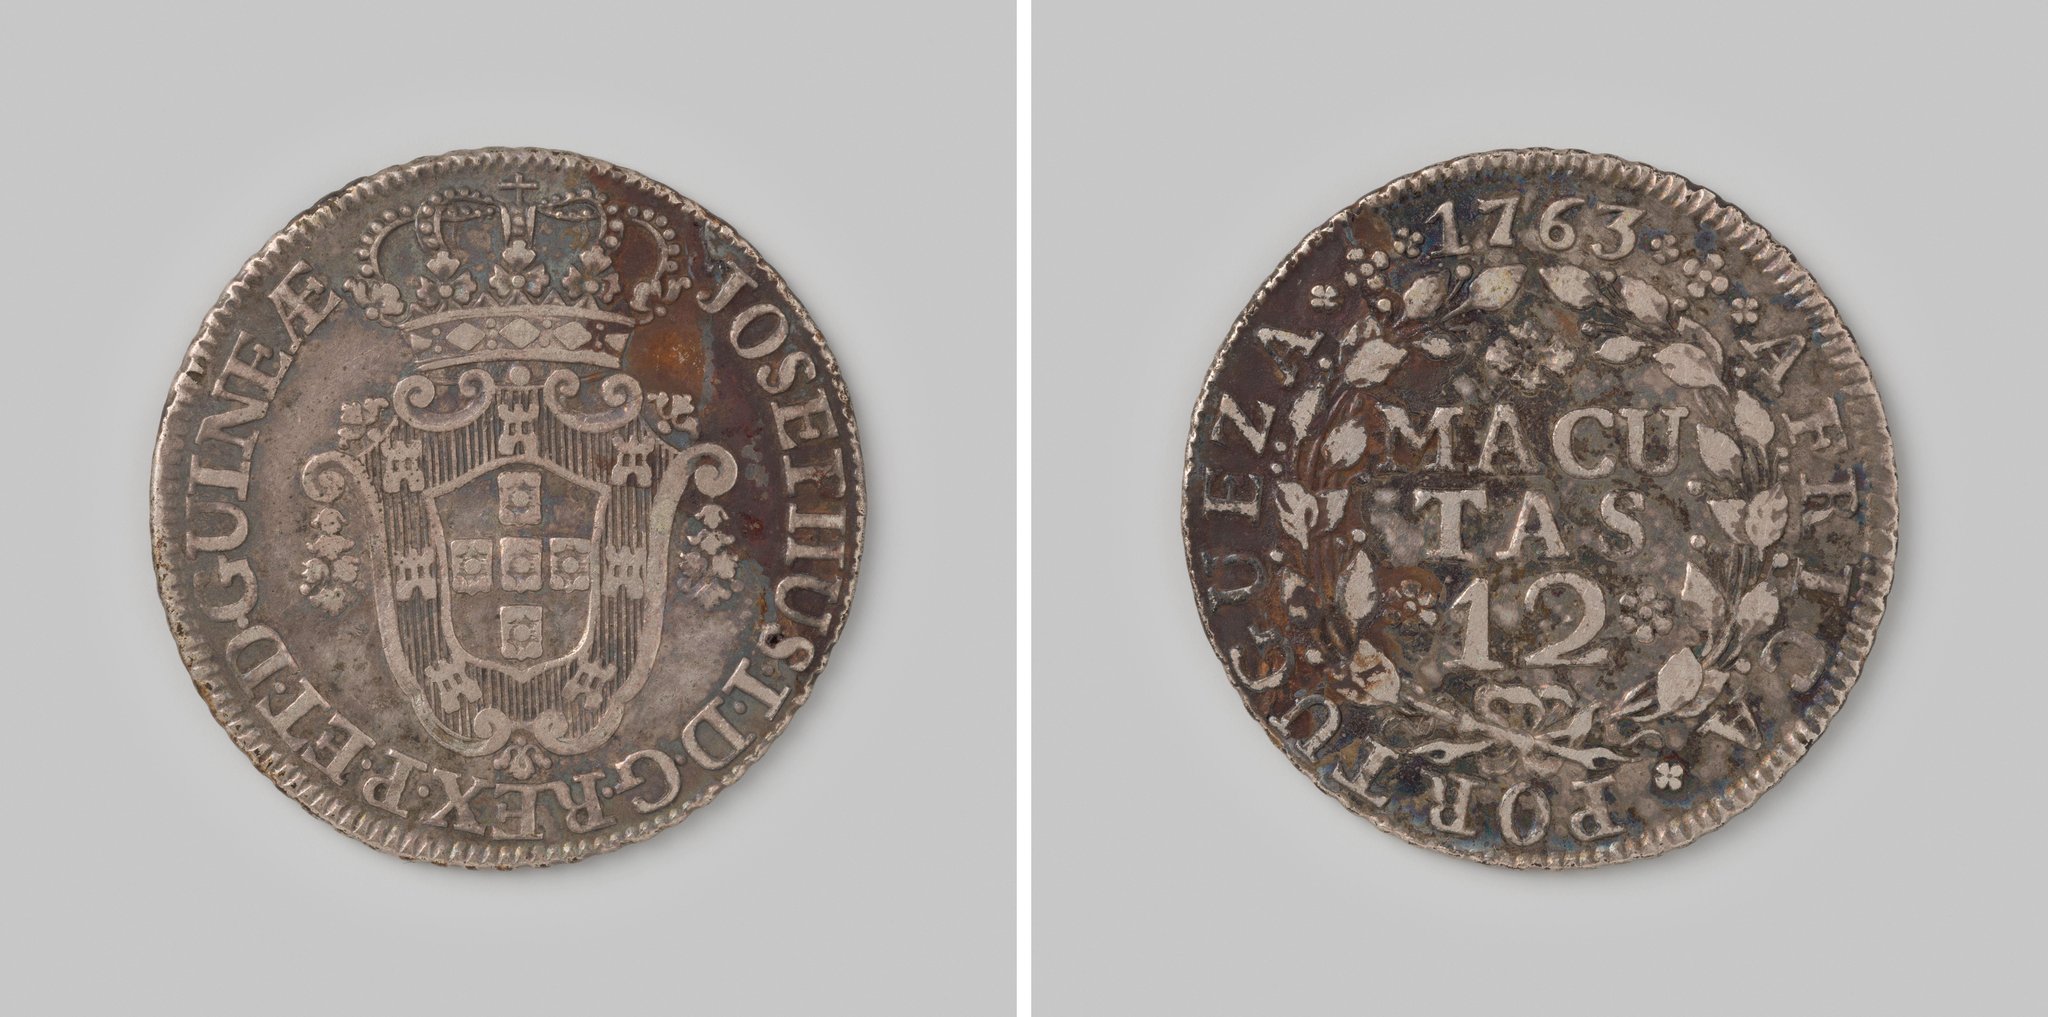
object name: coin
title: 12 macutas uit Angola van de Portugese koning José I, 1763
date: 1763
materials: silver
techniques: striking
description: Zilveren munt. Voorzijde: barok wapenschild van Portugal, waarboven kroon. Keerzijde: tussen twee samengebonden takken in twee regels waarde-aanduiding: macutas 12. Omschrift: Africa Portugueza met jaartal bovenaan. Bloemrand.